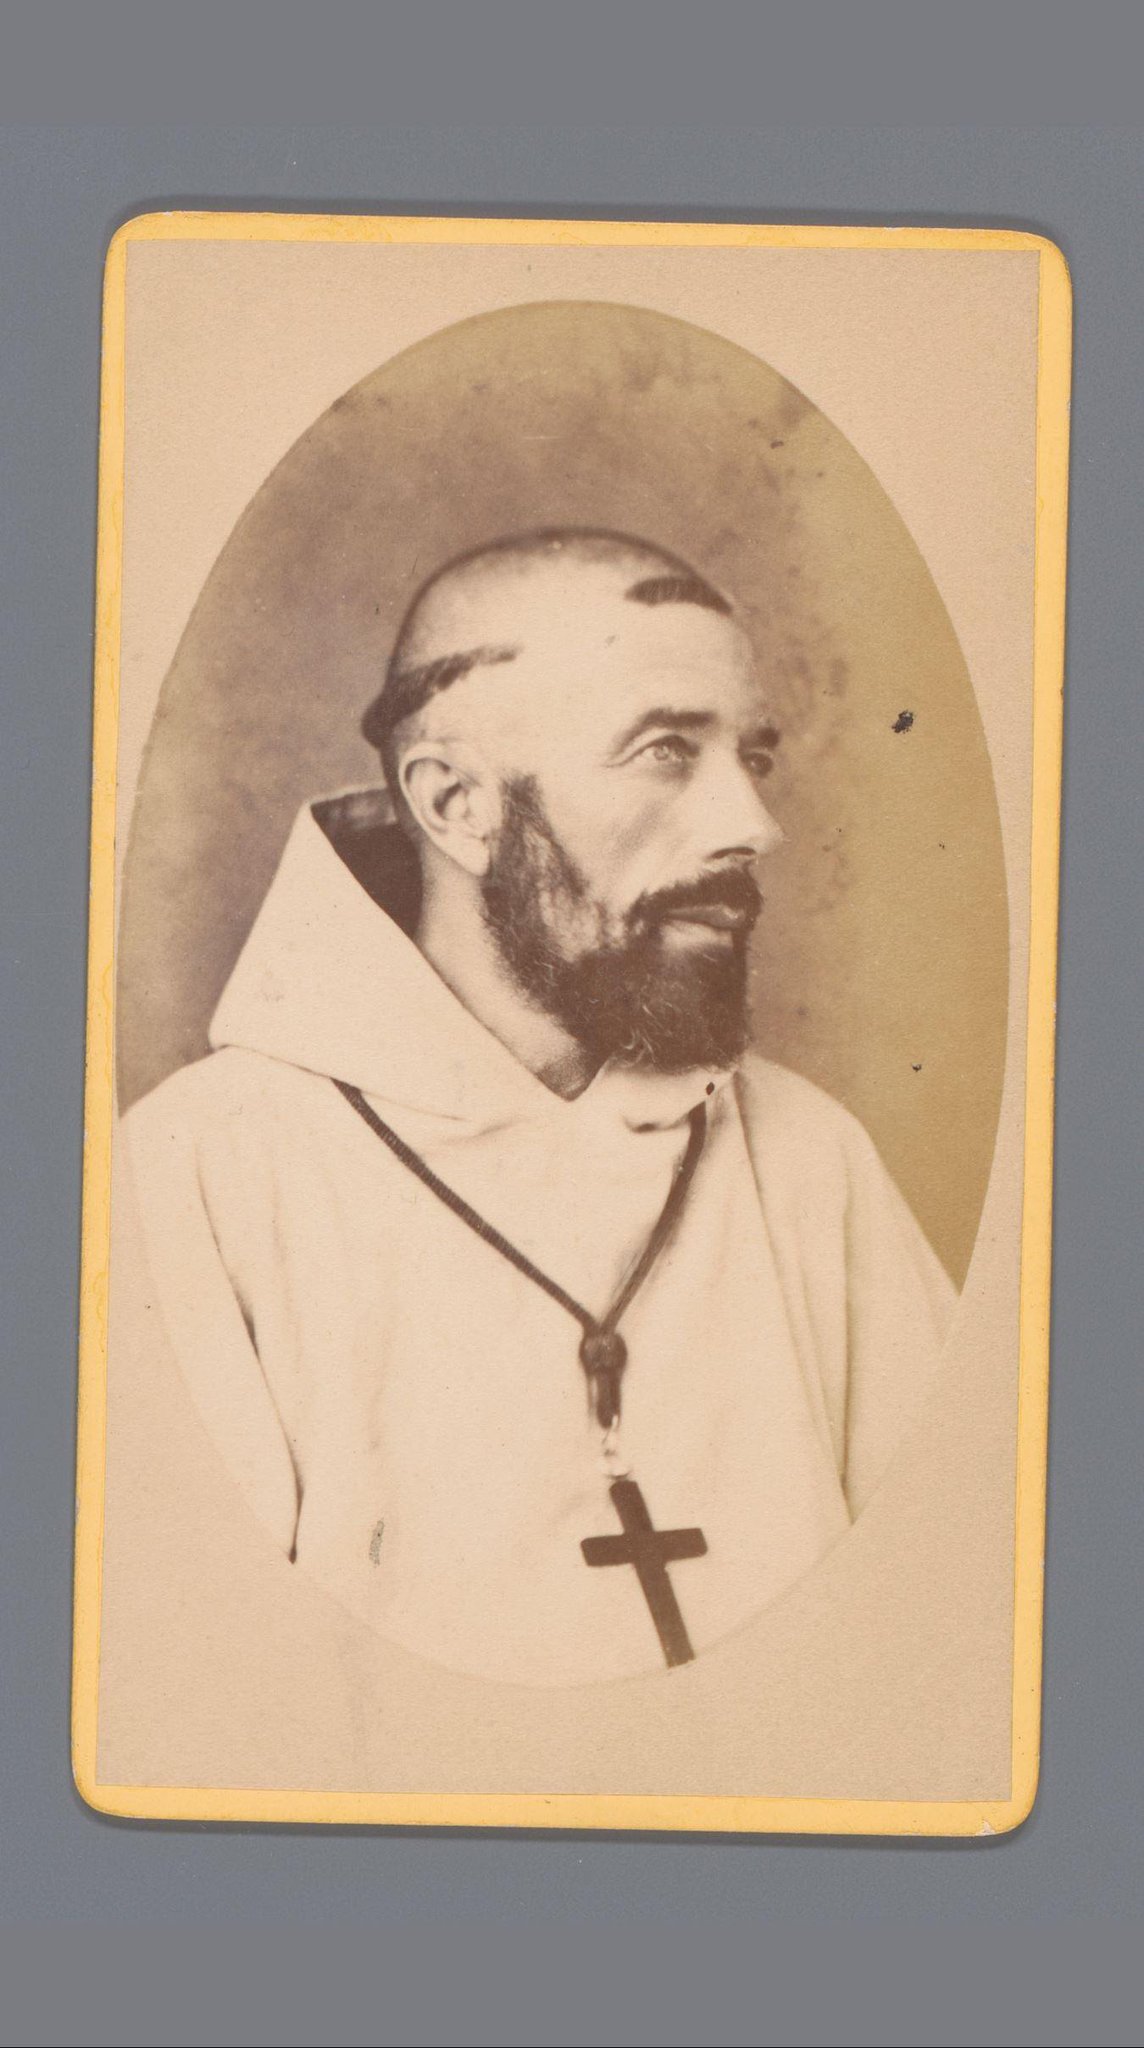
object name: photograph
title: Portret van een onbekende Cisterciënzermonnik in Staoueli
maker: Anonymous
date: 1855-1885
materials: cardboard, paper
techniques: albumen print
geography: staoueli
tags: monk(s), friar(s), anonymous historical person portrayed, monastic orders, monastic life: cistercians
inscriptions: inscription: ‘Photographie’, inscription: ‘1,50’